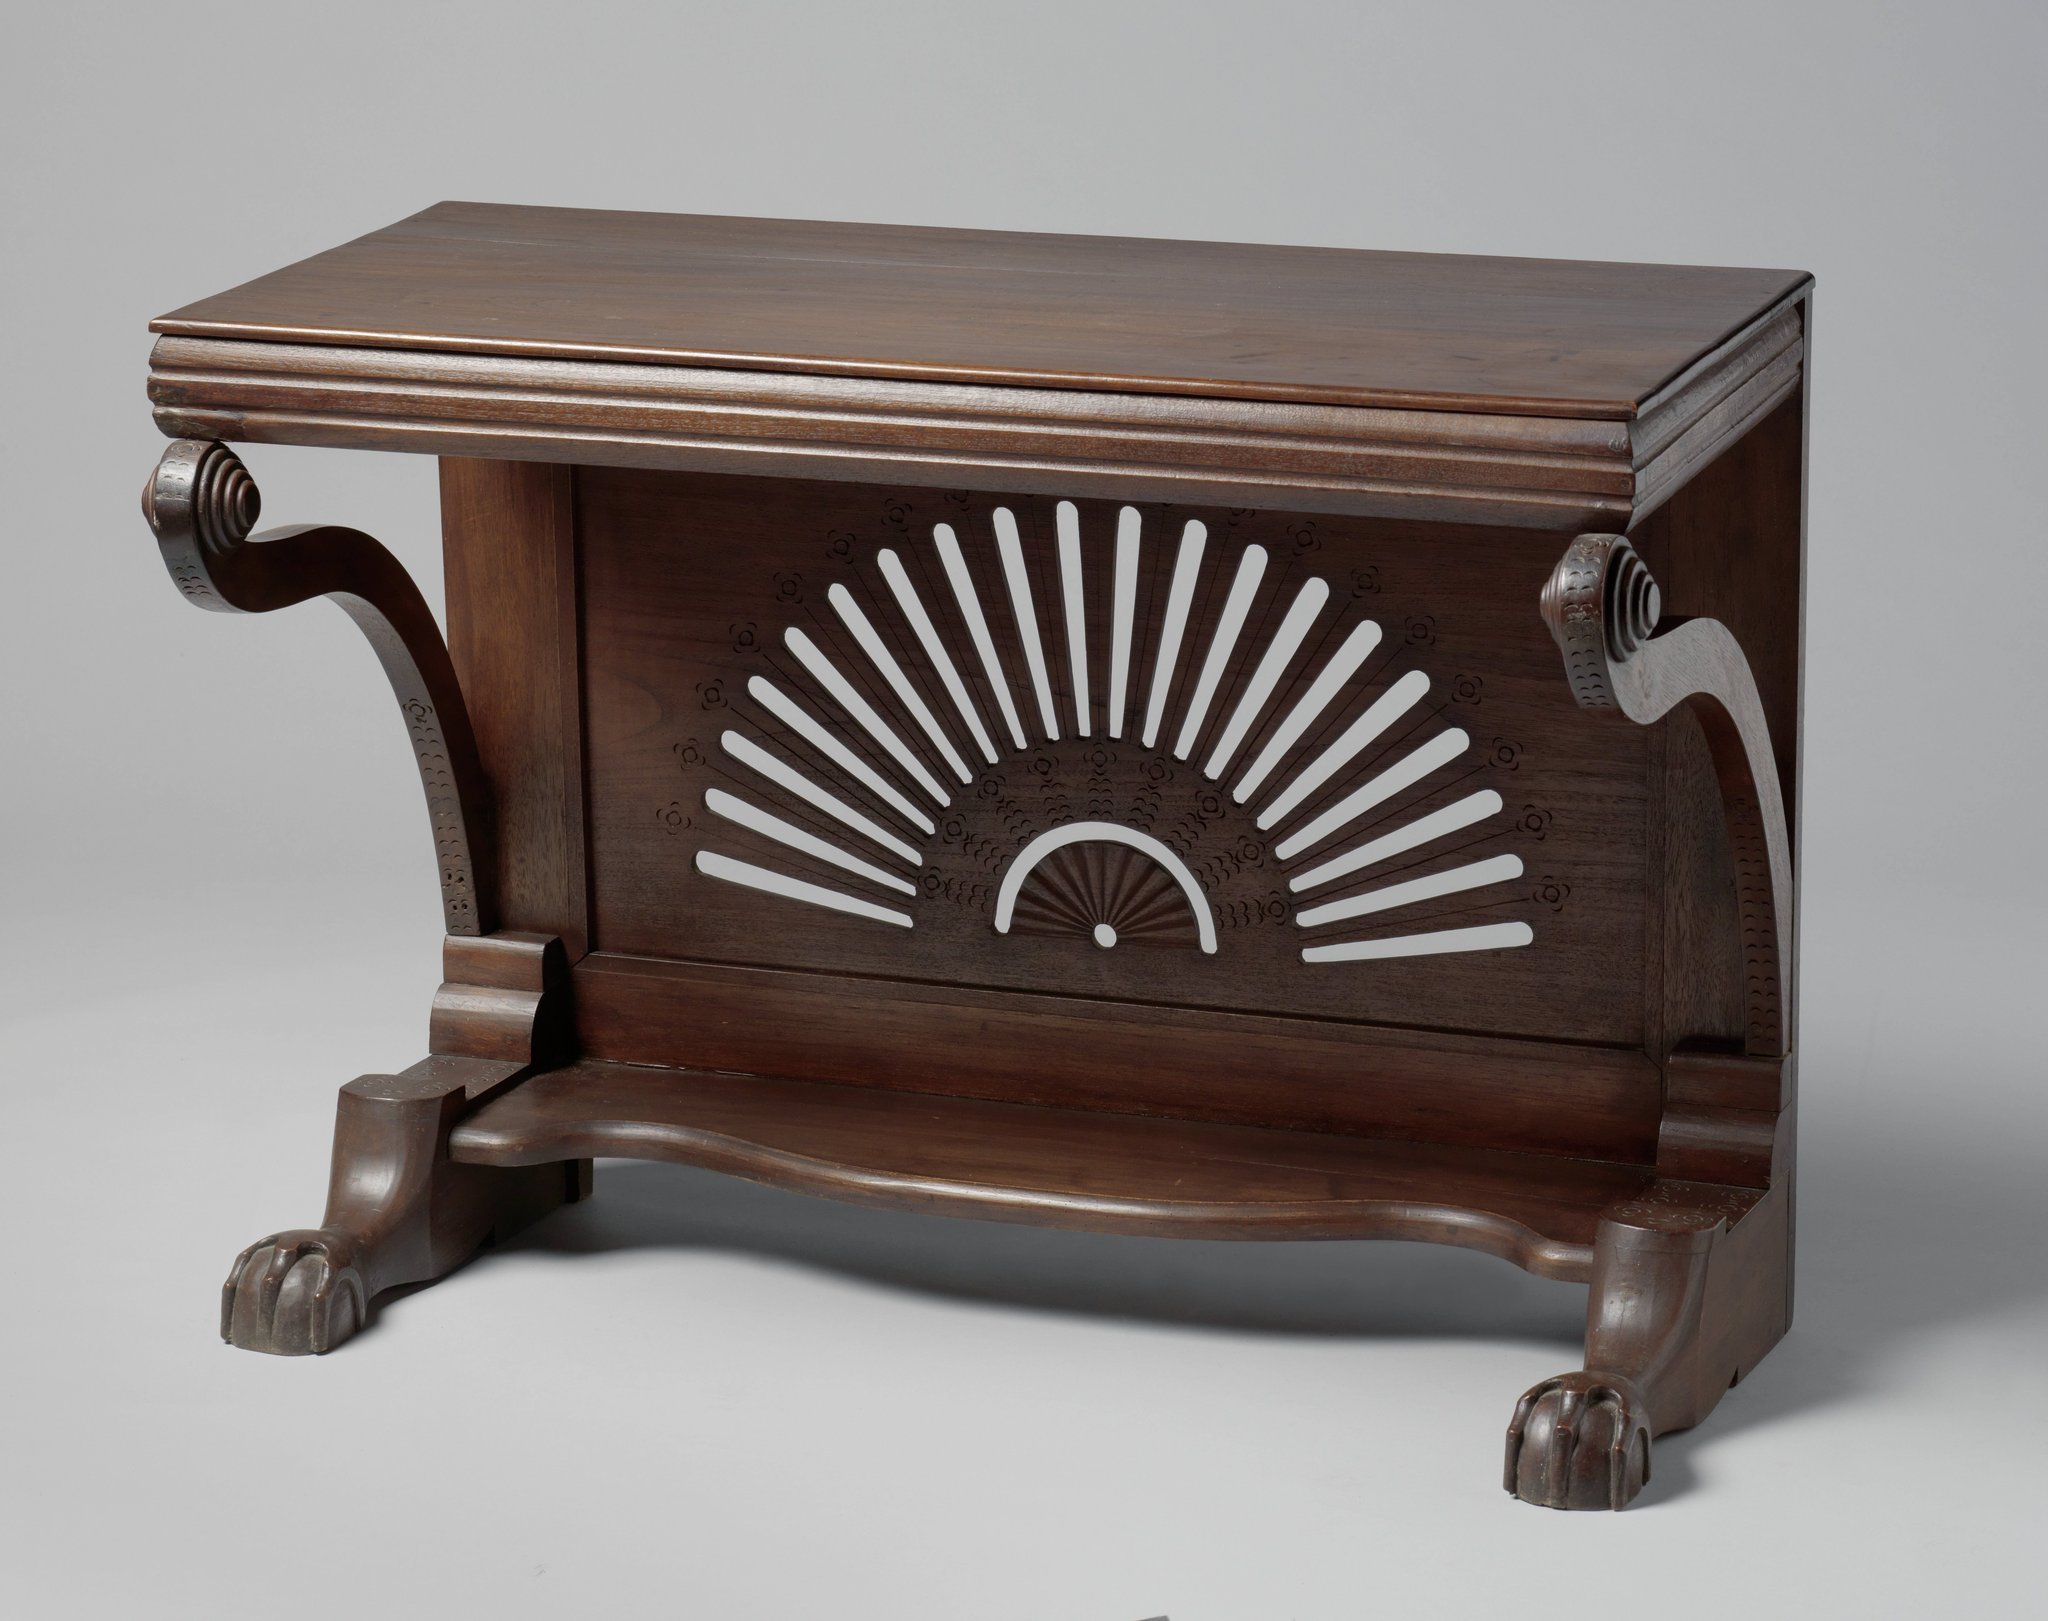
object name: solar chart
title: Wandtafel, z.g. "zonnetafel" van tropisch hout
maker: Anonymous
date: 1820-1849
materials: wood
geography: indonesia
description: Wandtafel, z.g. "zonnetafel" van tropisch hout. Het meubel rust op twee sleepoten, aan de voorzijde uitlopend in klauw-en-bal, het achterste gedeelte van boven versierd met uit halve maantjes opgebouwde bloemmotieven, eindigend in voluten. De poten worden verbonden door een blad met een gegolfde voorzijde. Daarboven de dichte achterwand, opengewerkt met een "zonnemotief" bestaande uit stralen rond een halve cirkel met in het midden een ronde opening. Deze opengewerkte versiering is aangevuld met ingegrifte motieven. Het geprofileerde bovenblad rust op gebogen consoles, versierd met halve maantjes.